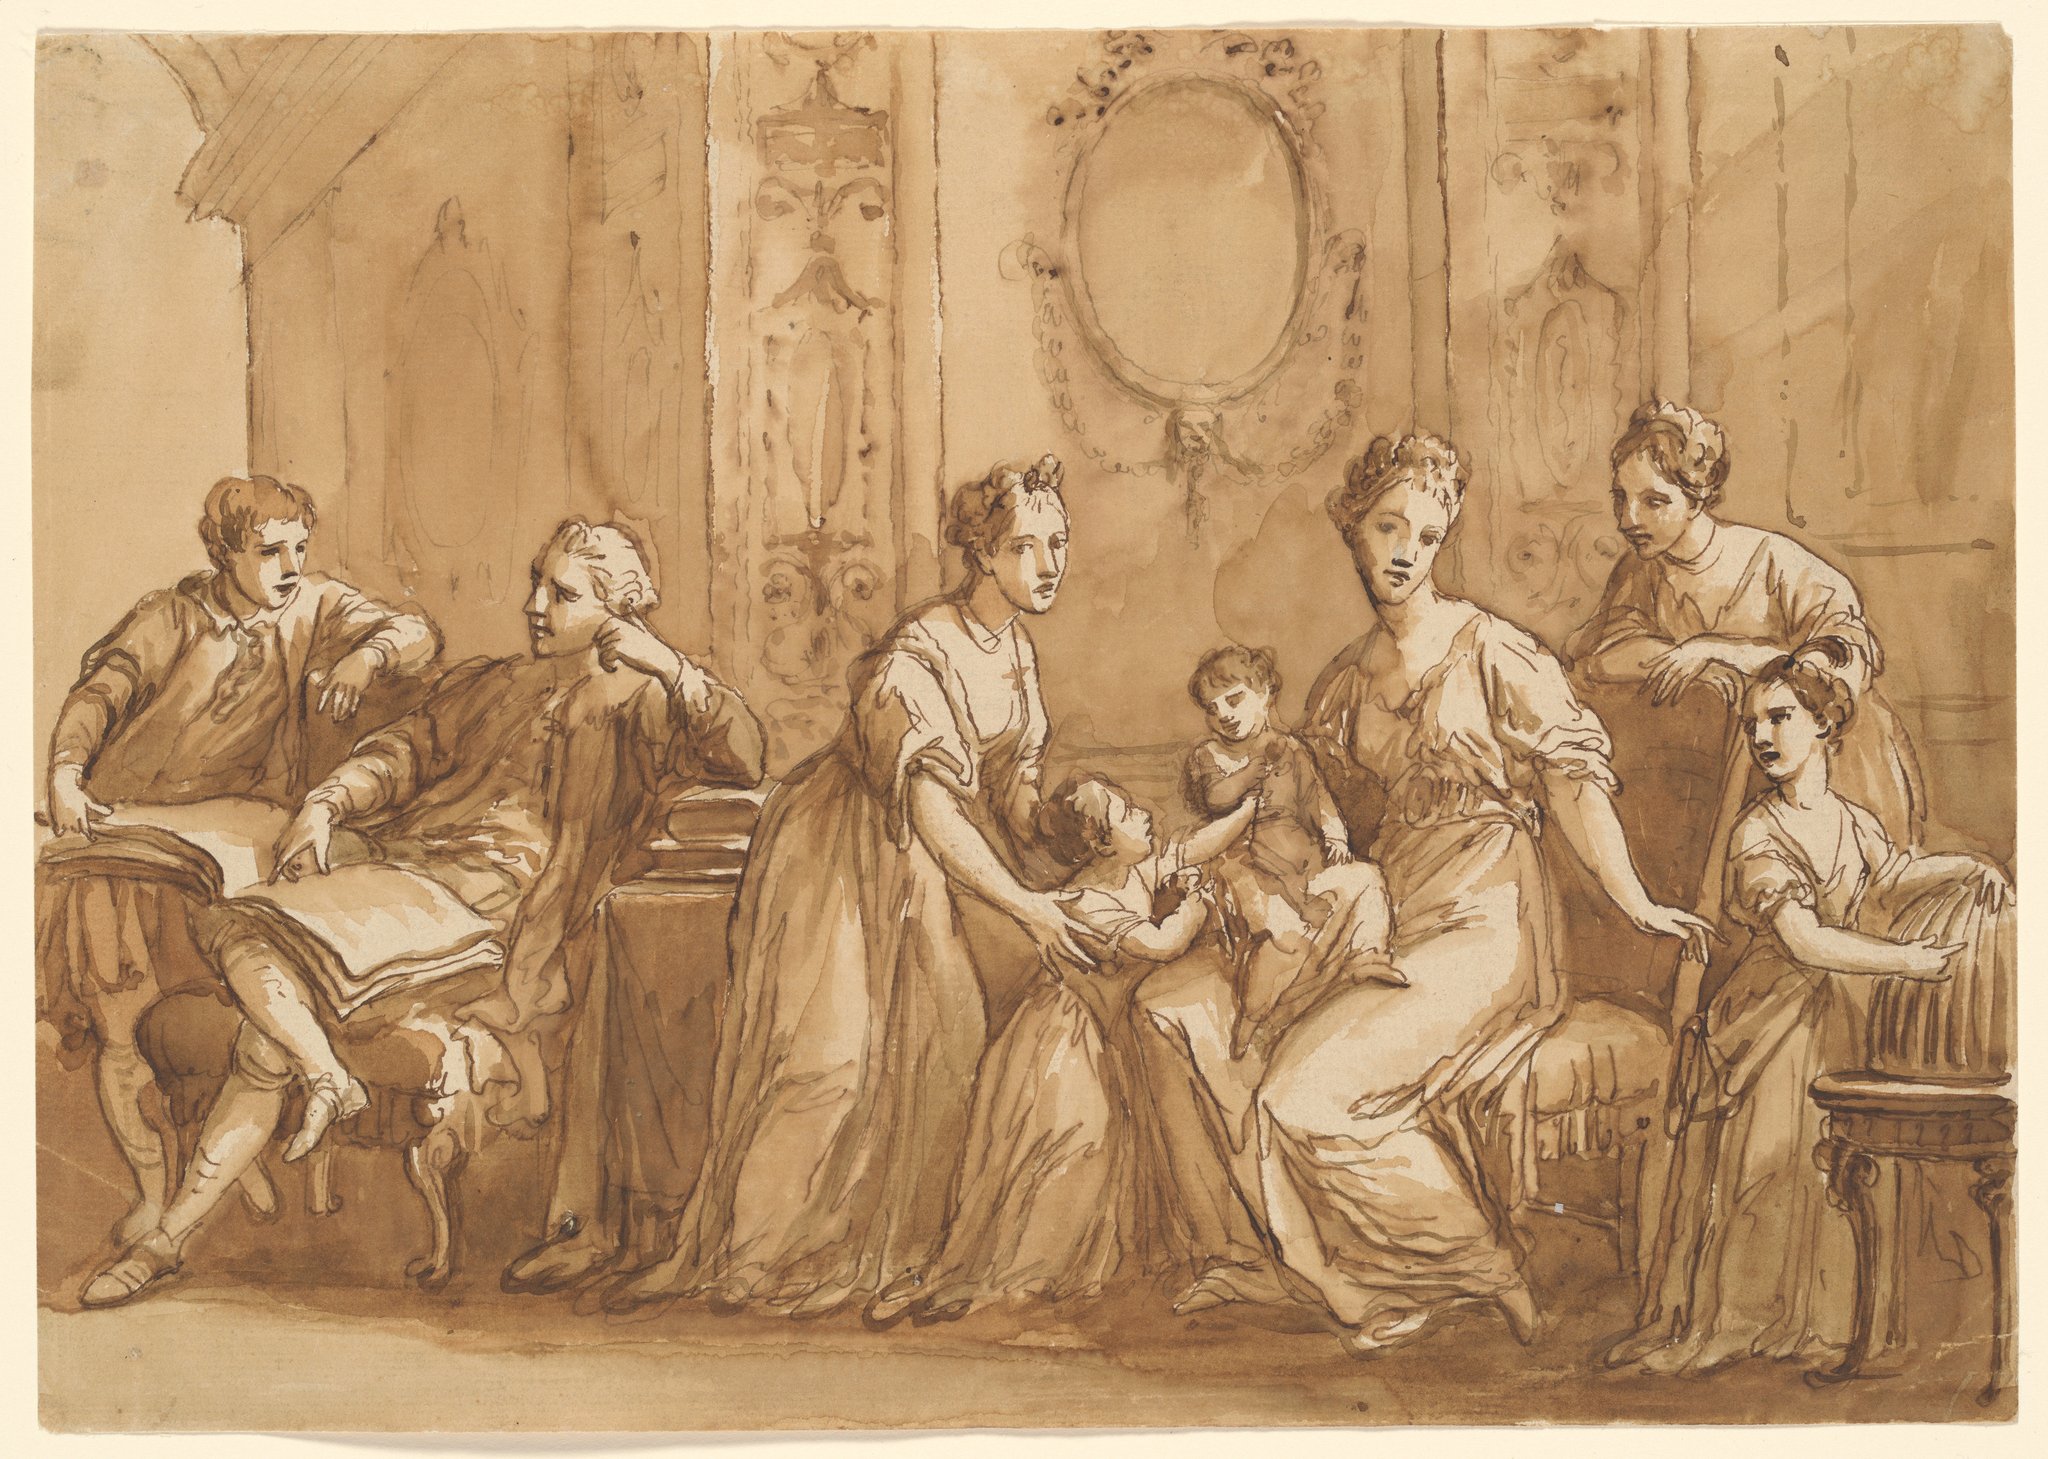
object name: drawing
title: An English Family Group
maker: antonio zucchi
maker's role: artist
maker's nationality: italian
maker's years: 1726-1796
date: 1767-1800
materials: ink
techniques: pen, wash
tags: children,men,women,family